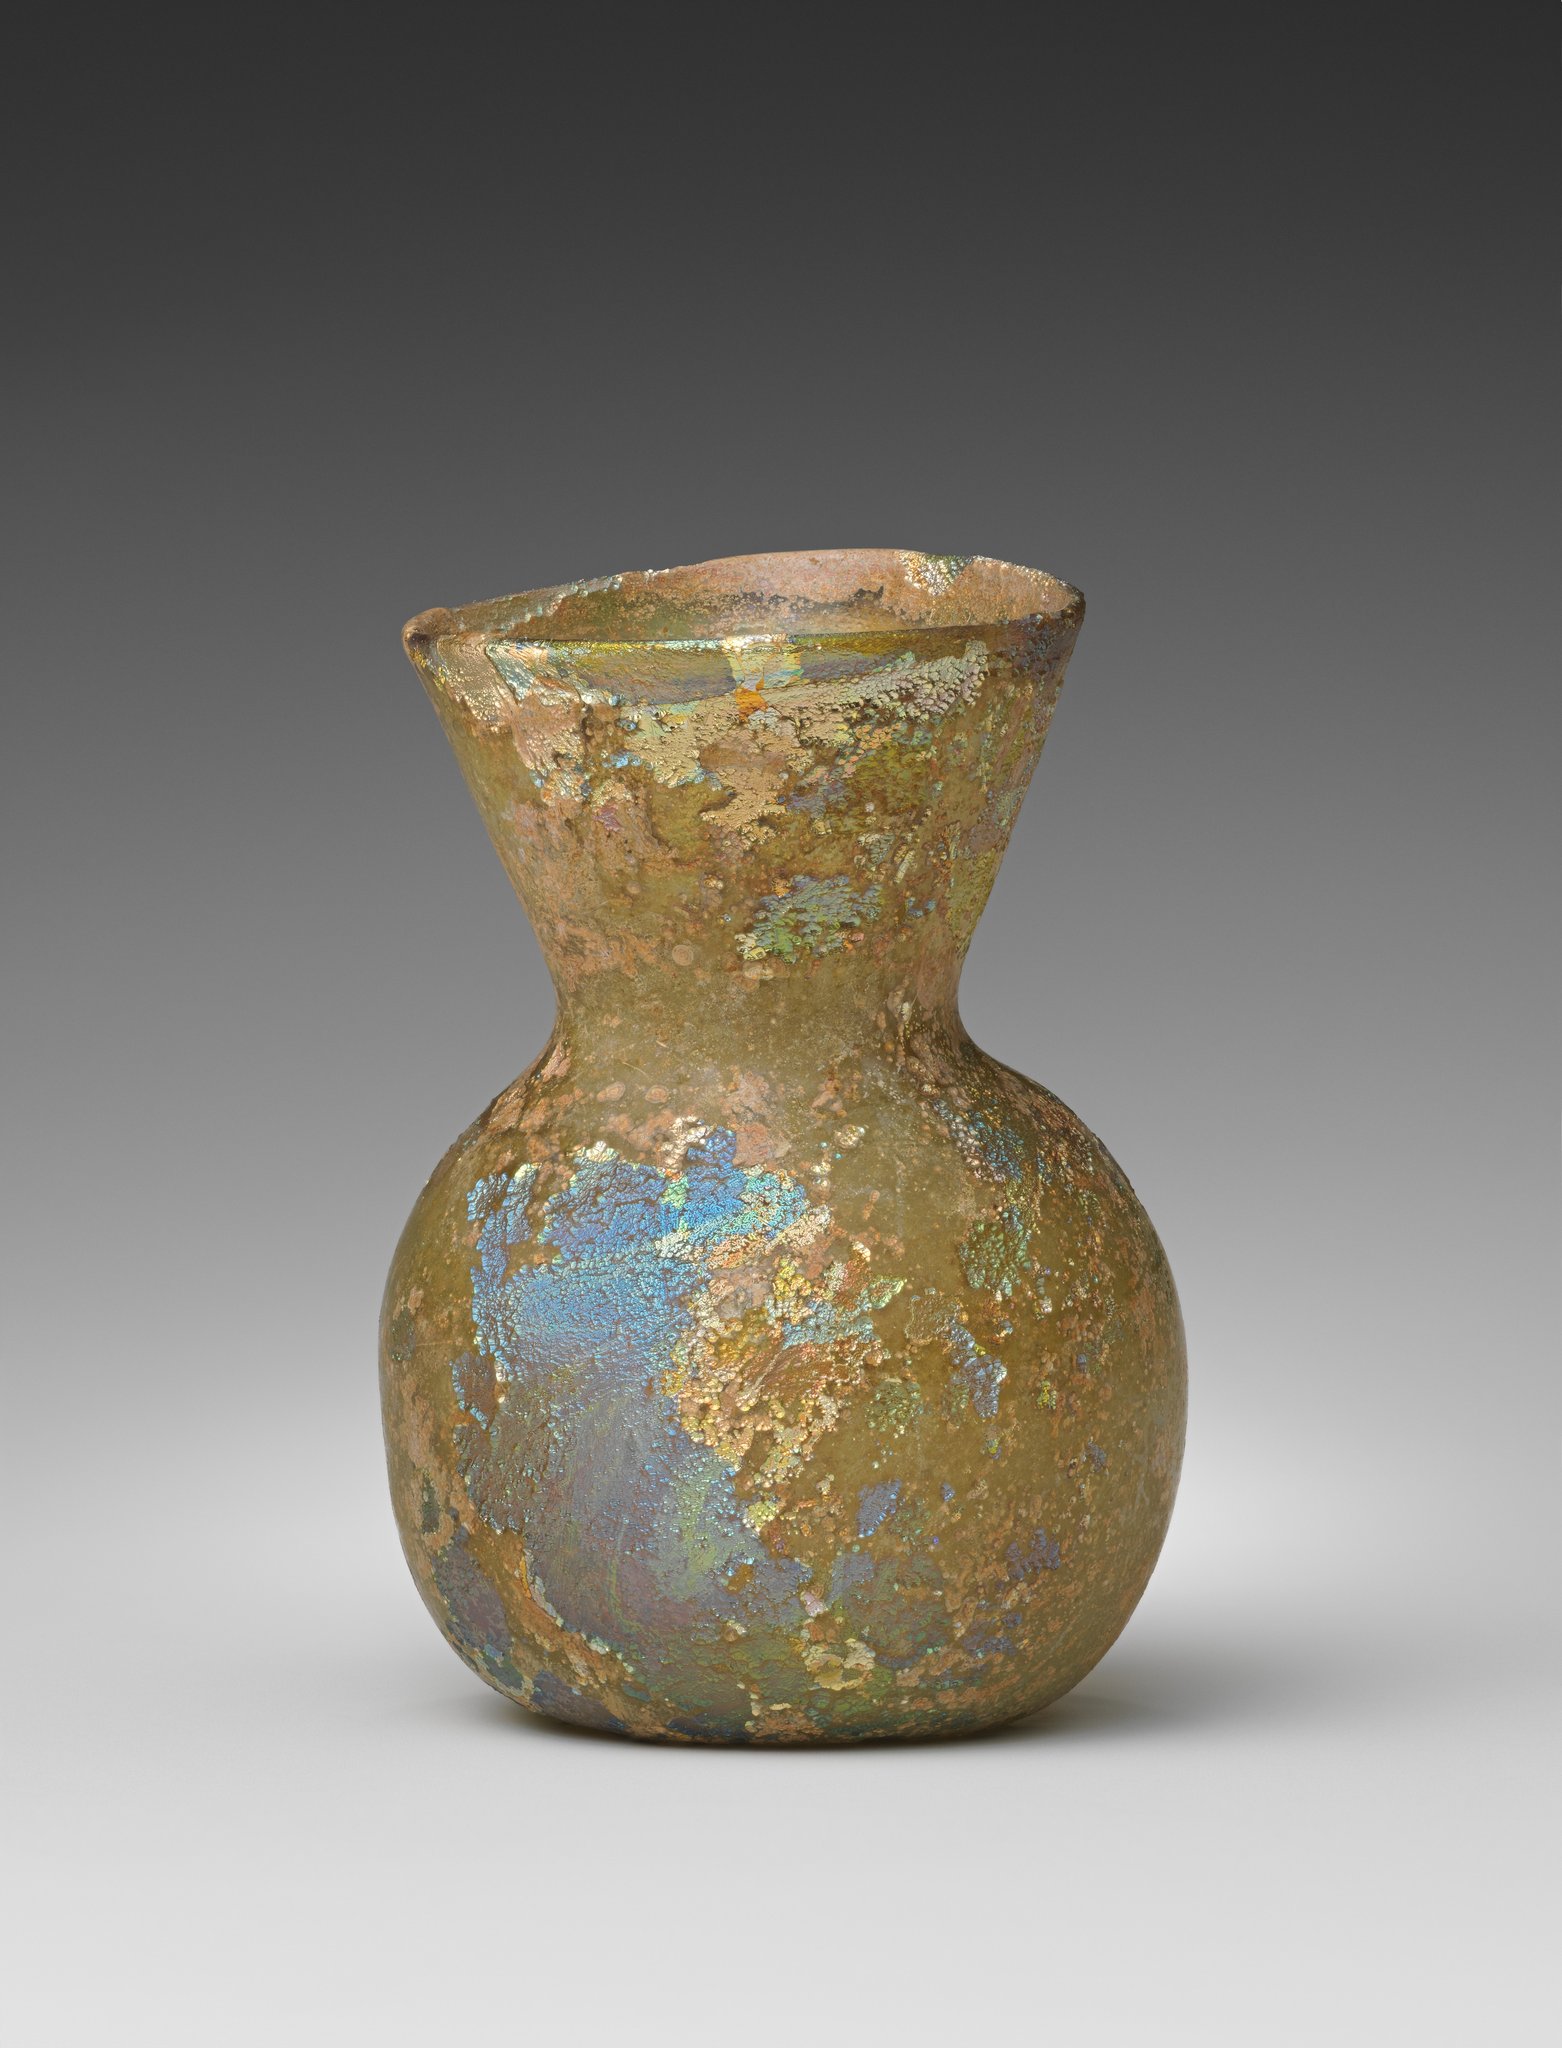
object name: jar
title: Glass jar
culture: roman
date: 301-500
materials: glass